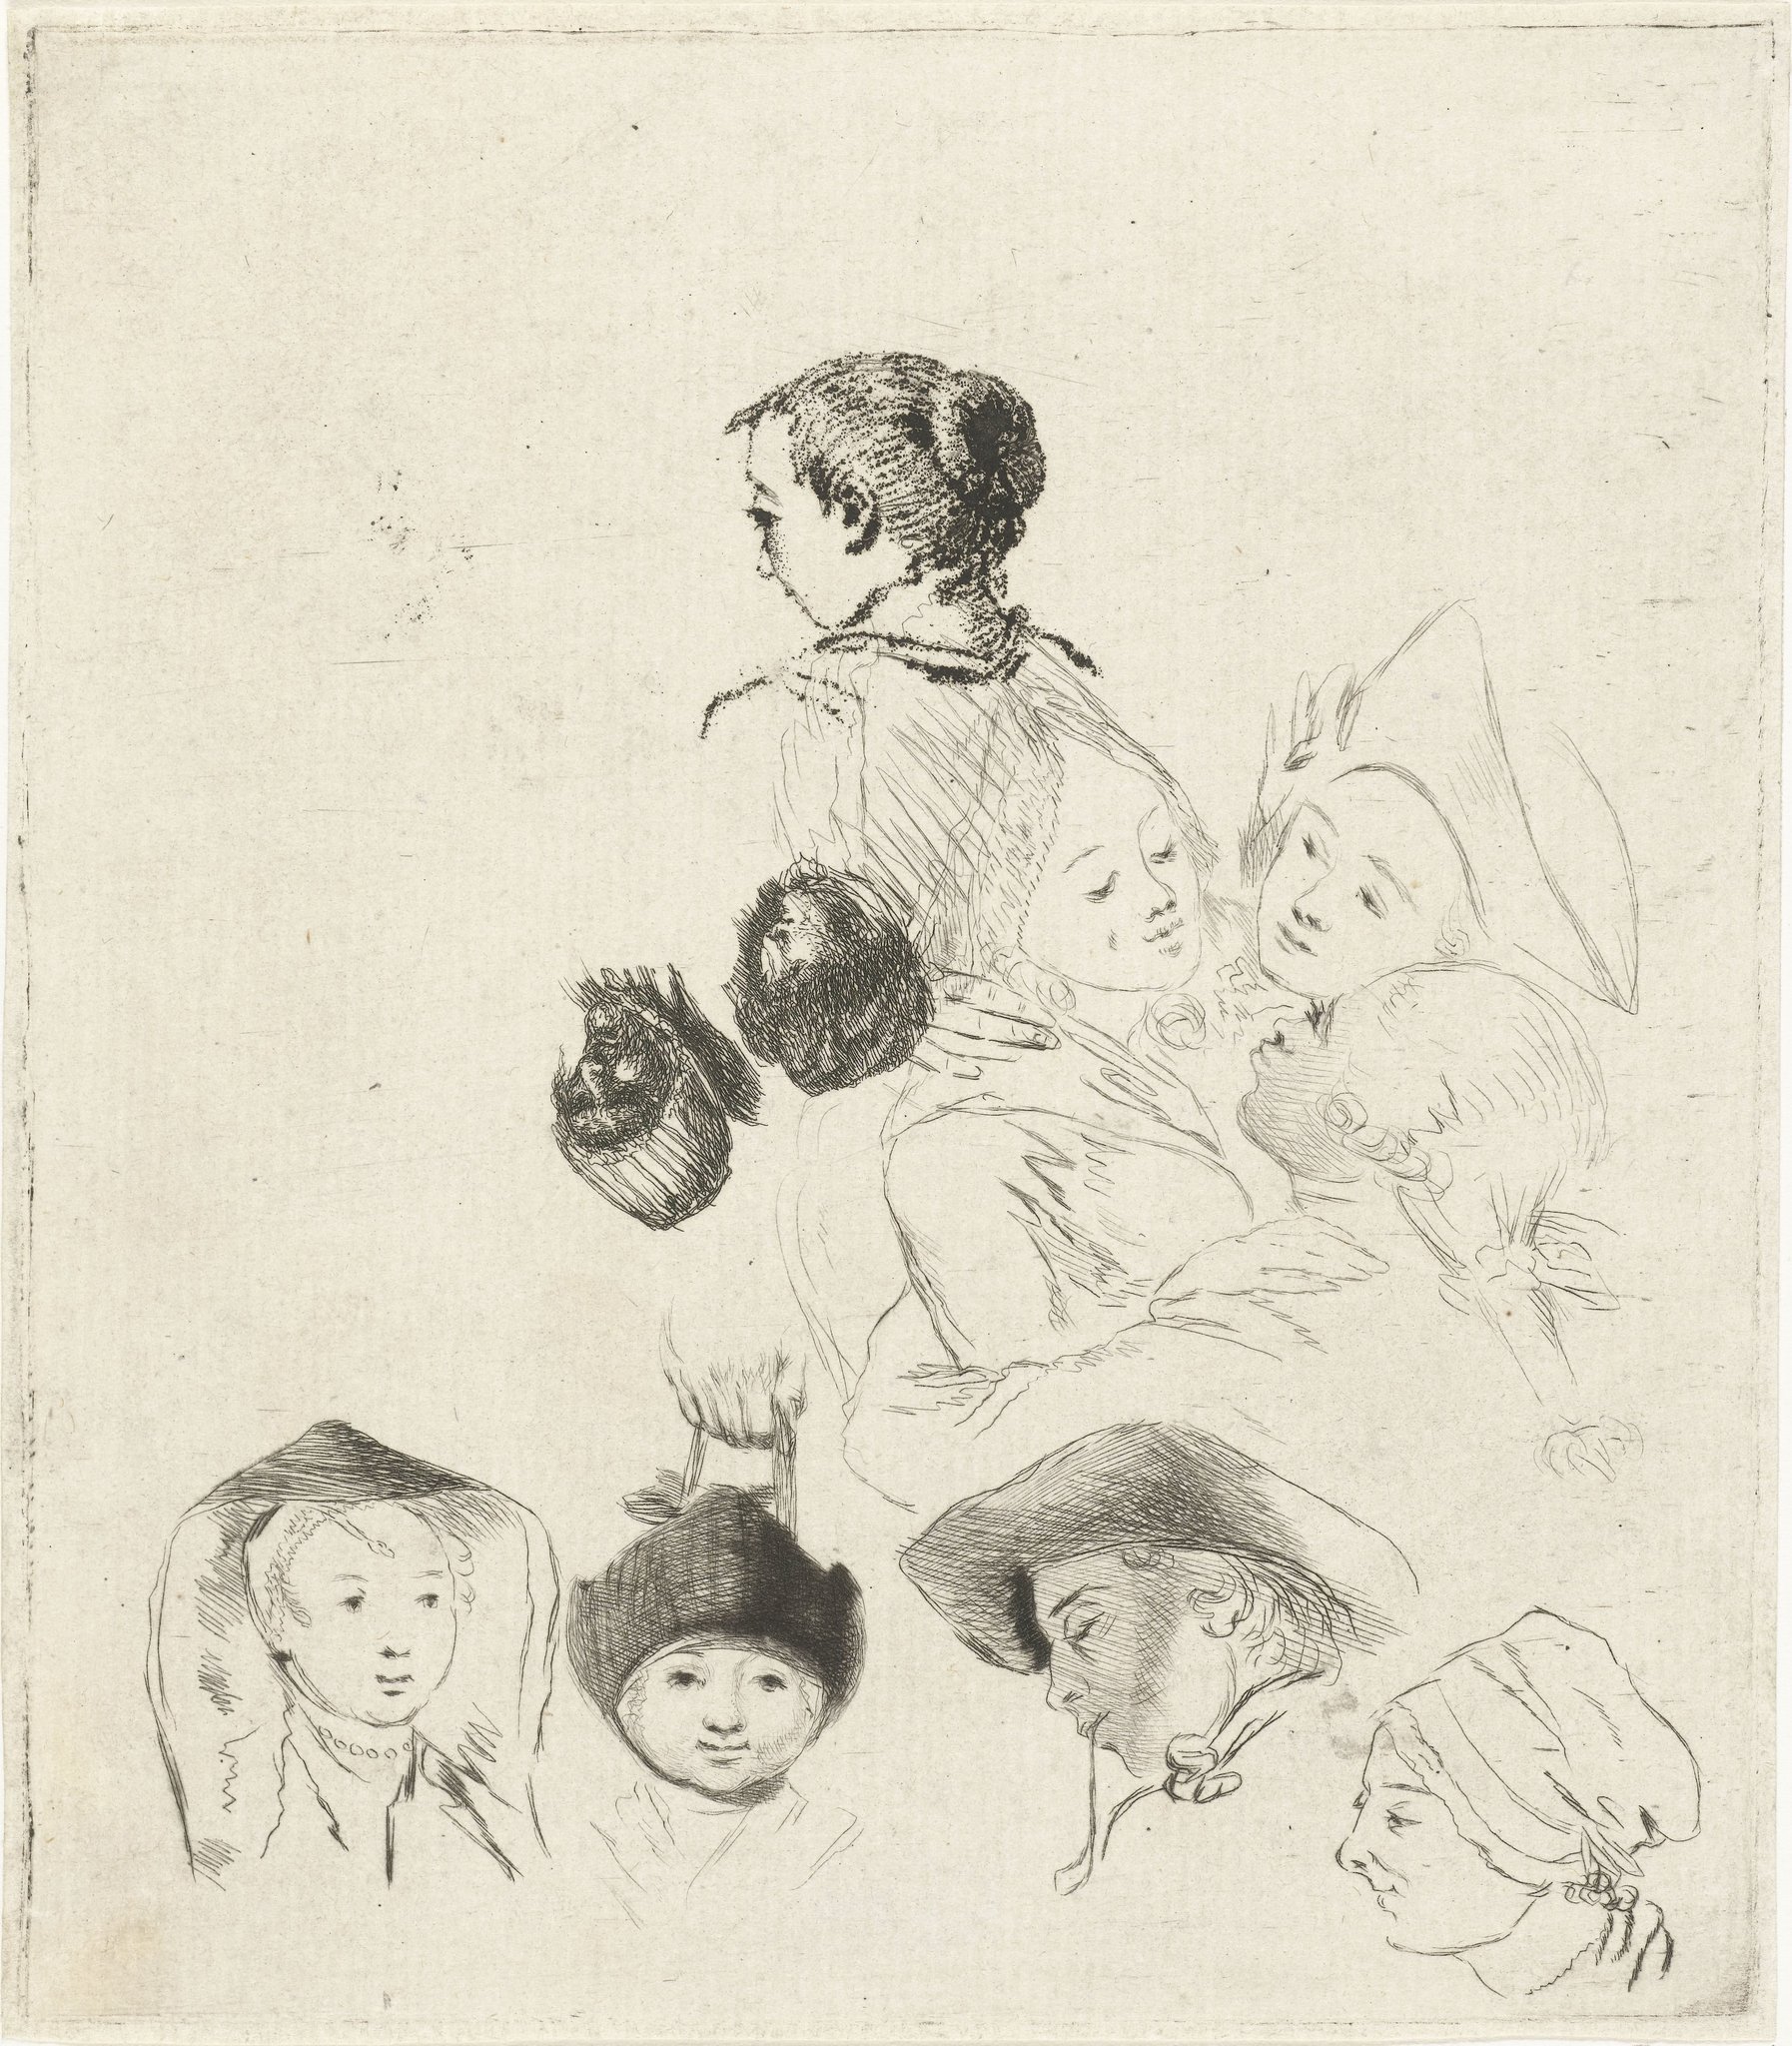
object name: print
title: Studieblad met tien hoofden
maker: louis bernard coclers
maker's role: draughtsman, print maker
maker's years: 1741-1817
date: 1756-1817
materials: paper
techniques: printmaking, drypoint, etching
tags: head-gear: cap (+ women's clothes)